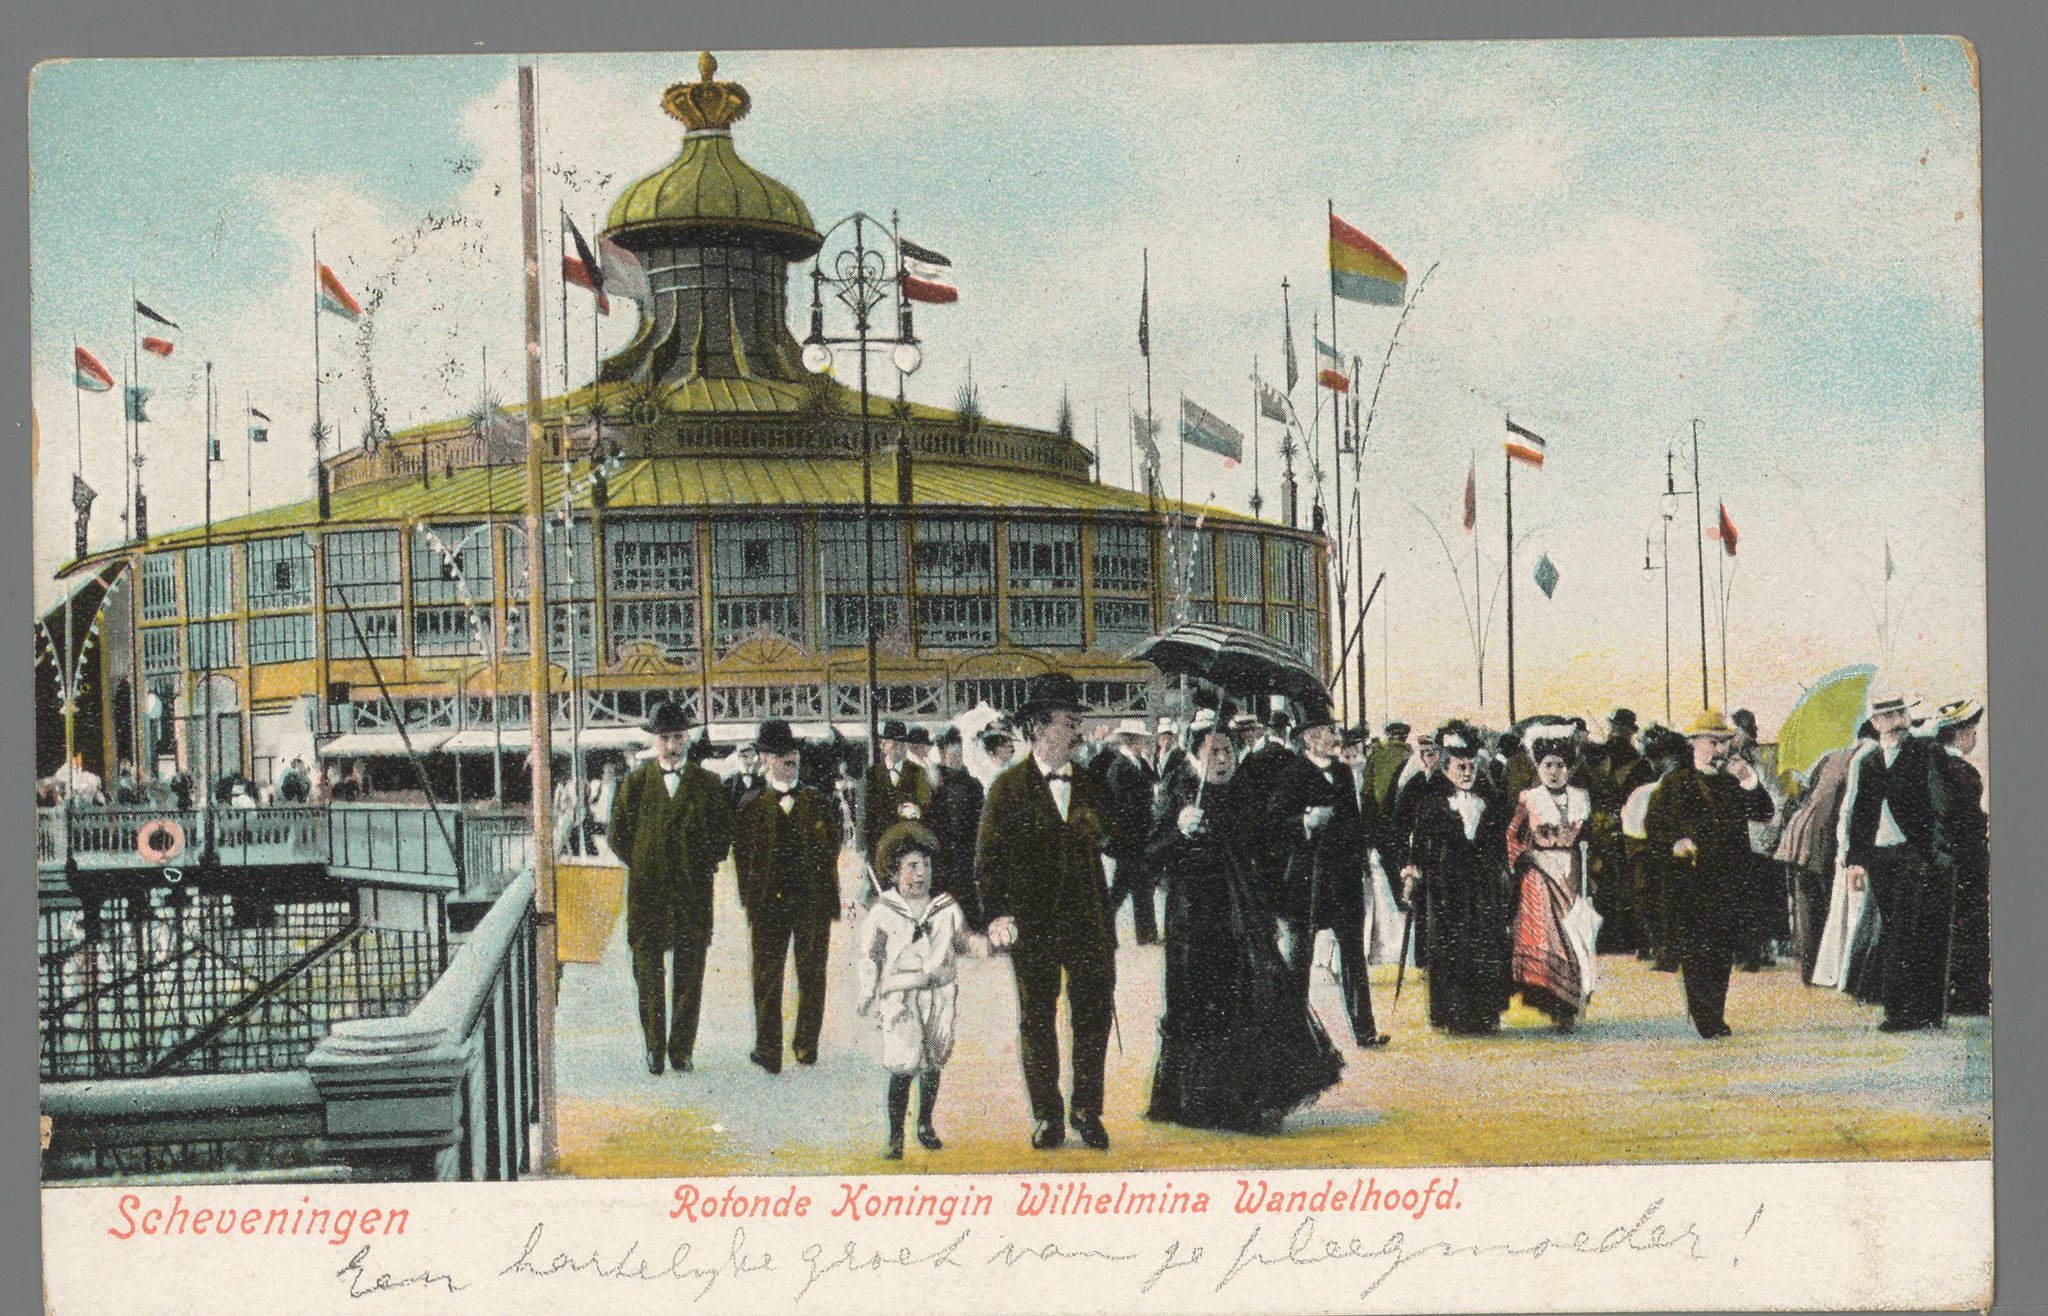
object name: photomechanical print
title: Schaefers Kunst-Chromo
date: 1897-1904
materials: cardboard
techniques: lithograph, writing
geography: scheveningen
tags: pier, quay, wharf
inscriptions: postage stamp